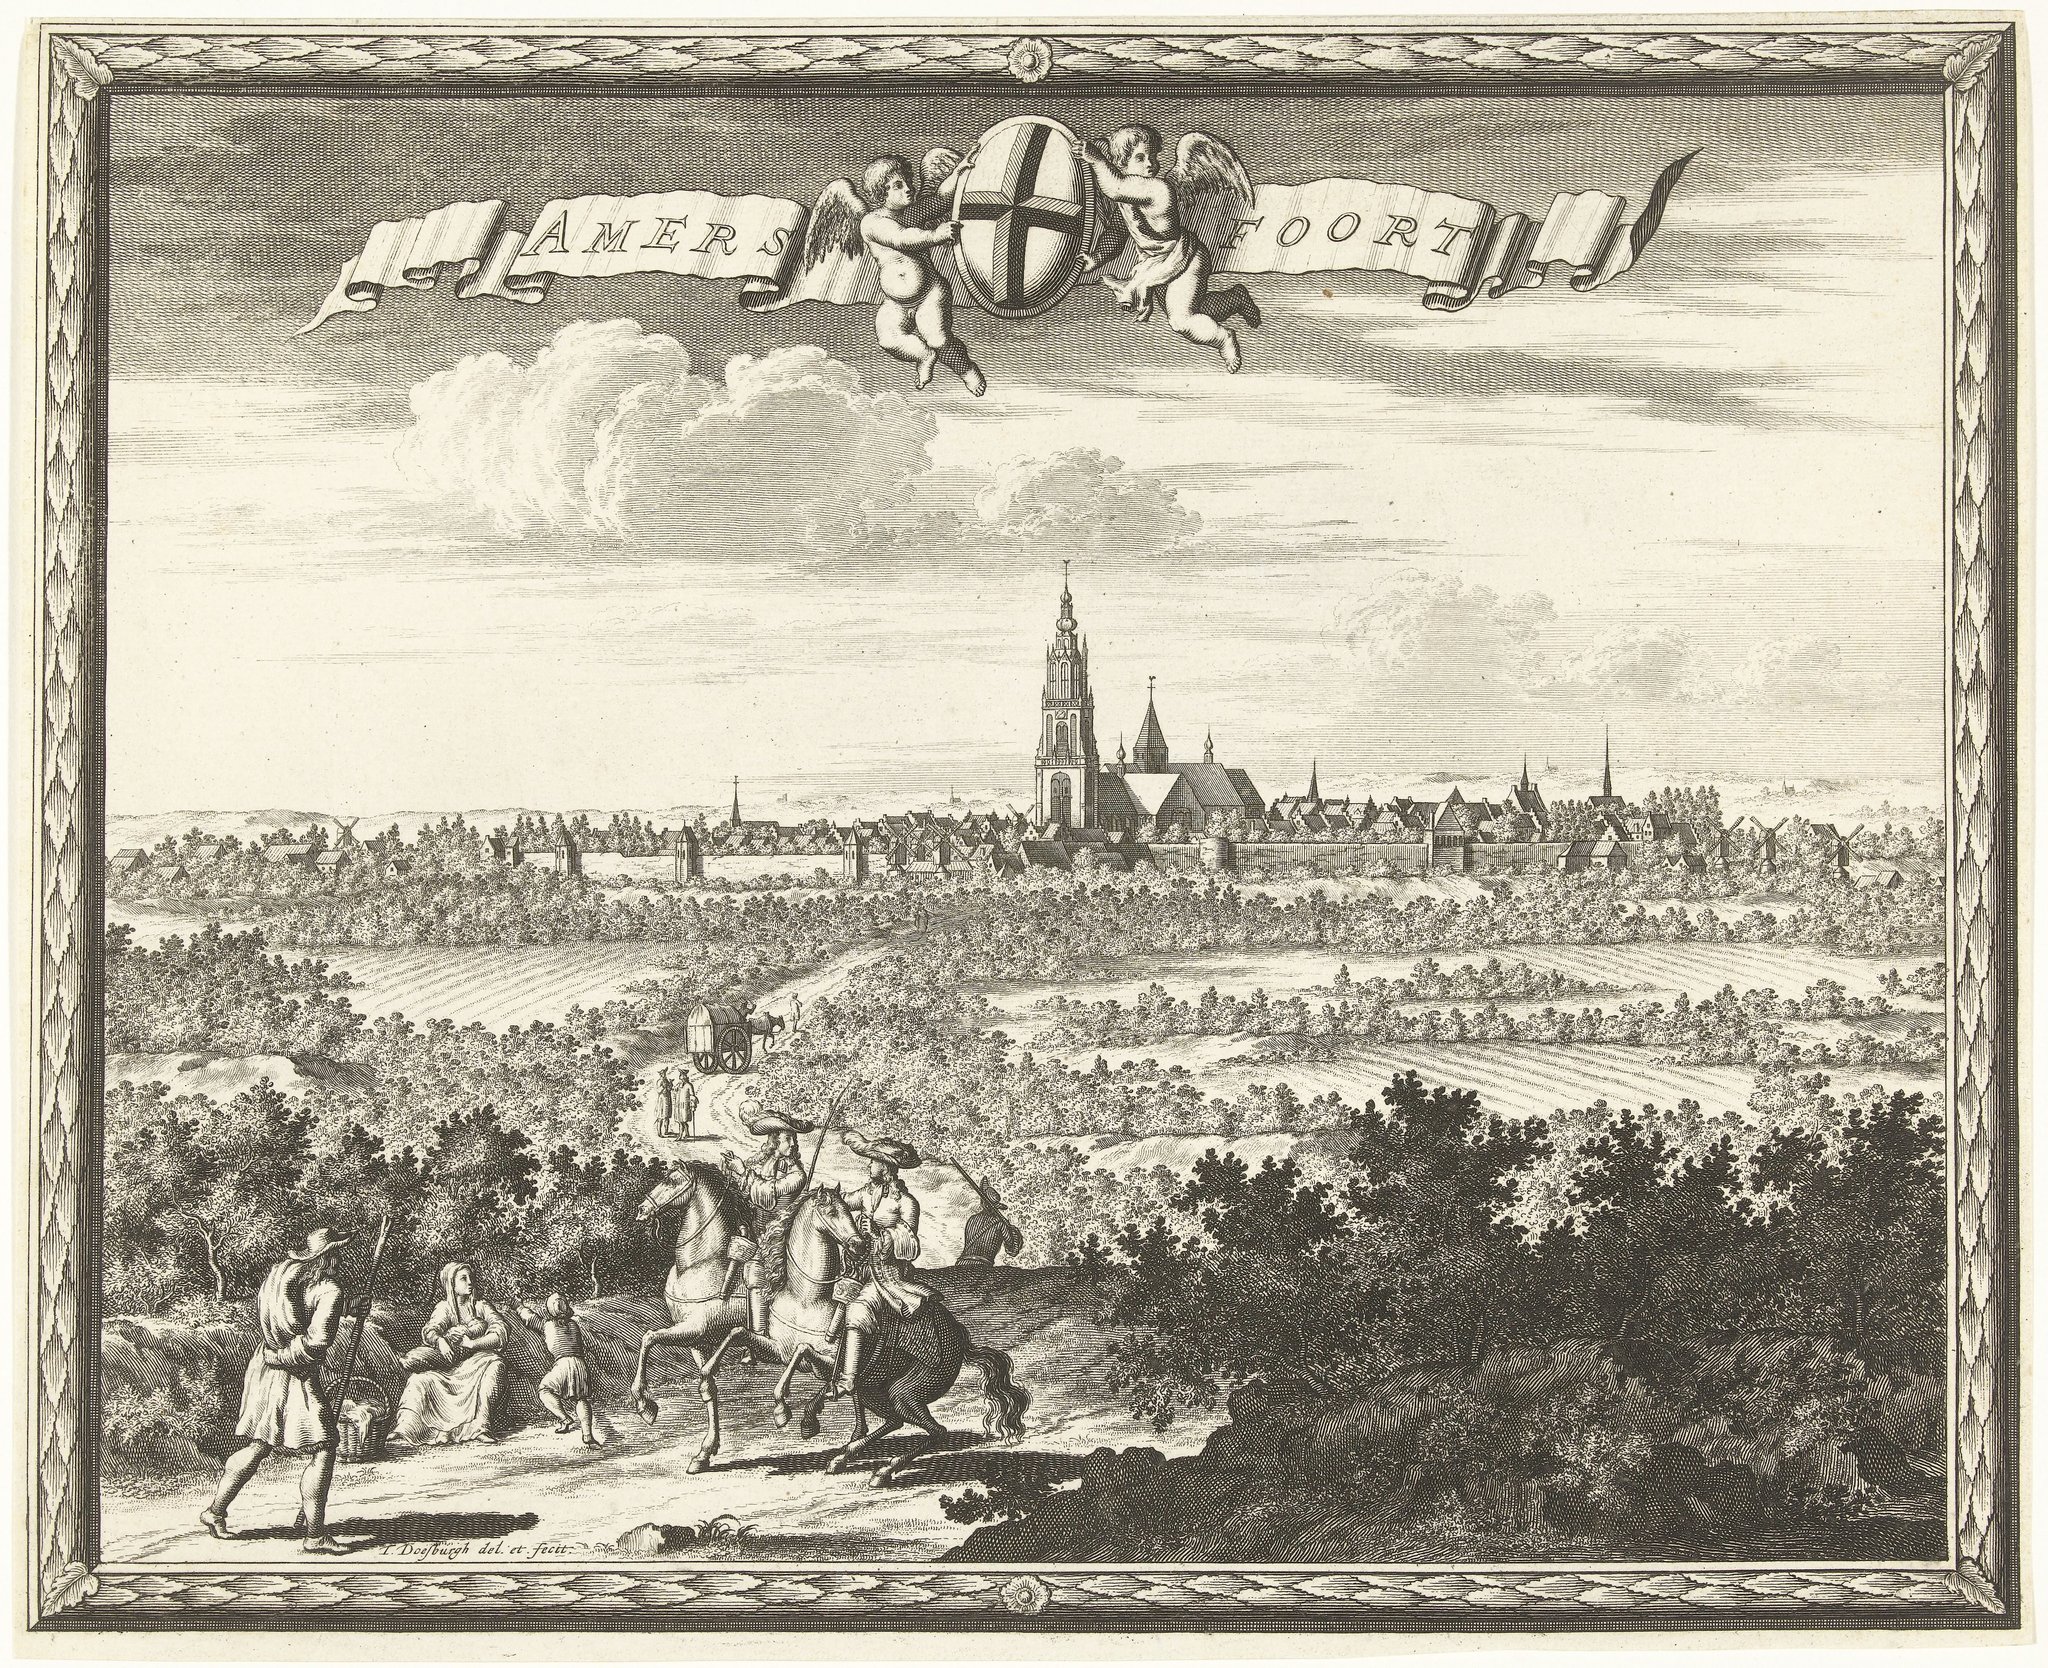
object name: print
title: Gezicht op Amersfoort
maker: thomas doesburgh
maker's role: print maker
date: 1692-1714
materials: paper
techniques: engraving, etching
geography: netherlands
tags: prospect of city, town panorama, silhouette of city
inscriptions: collector's mark: Lugt 195